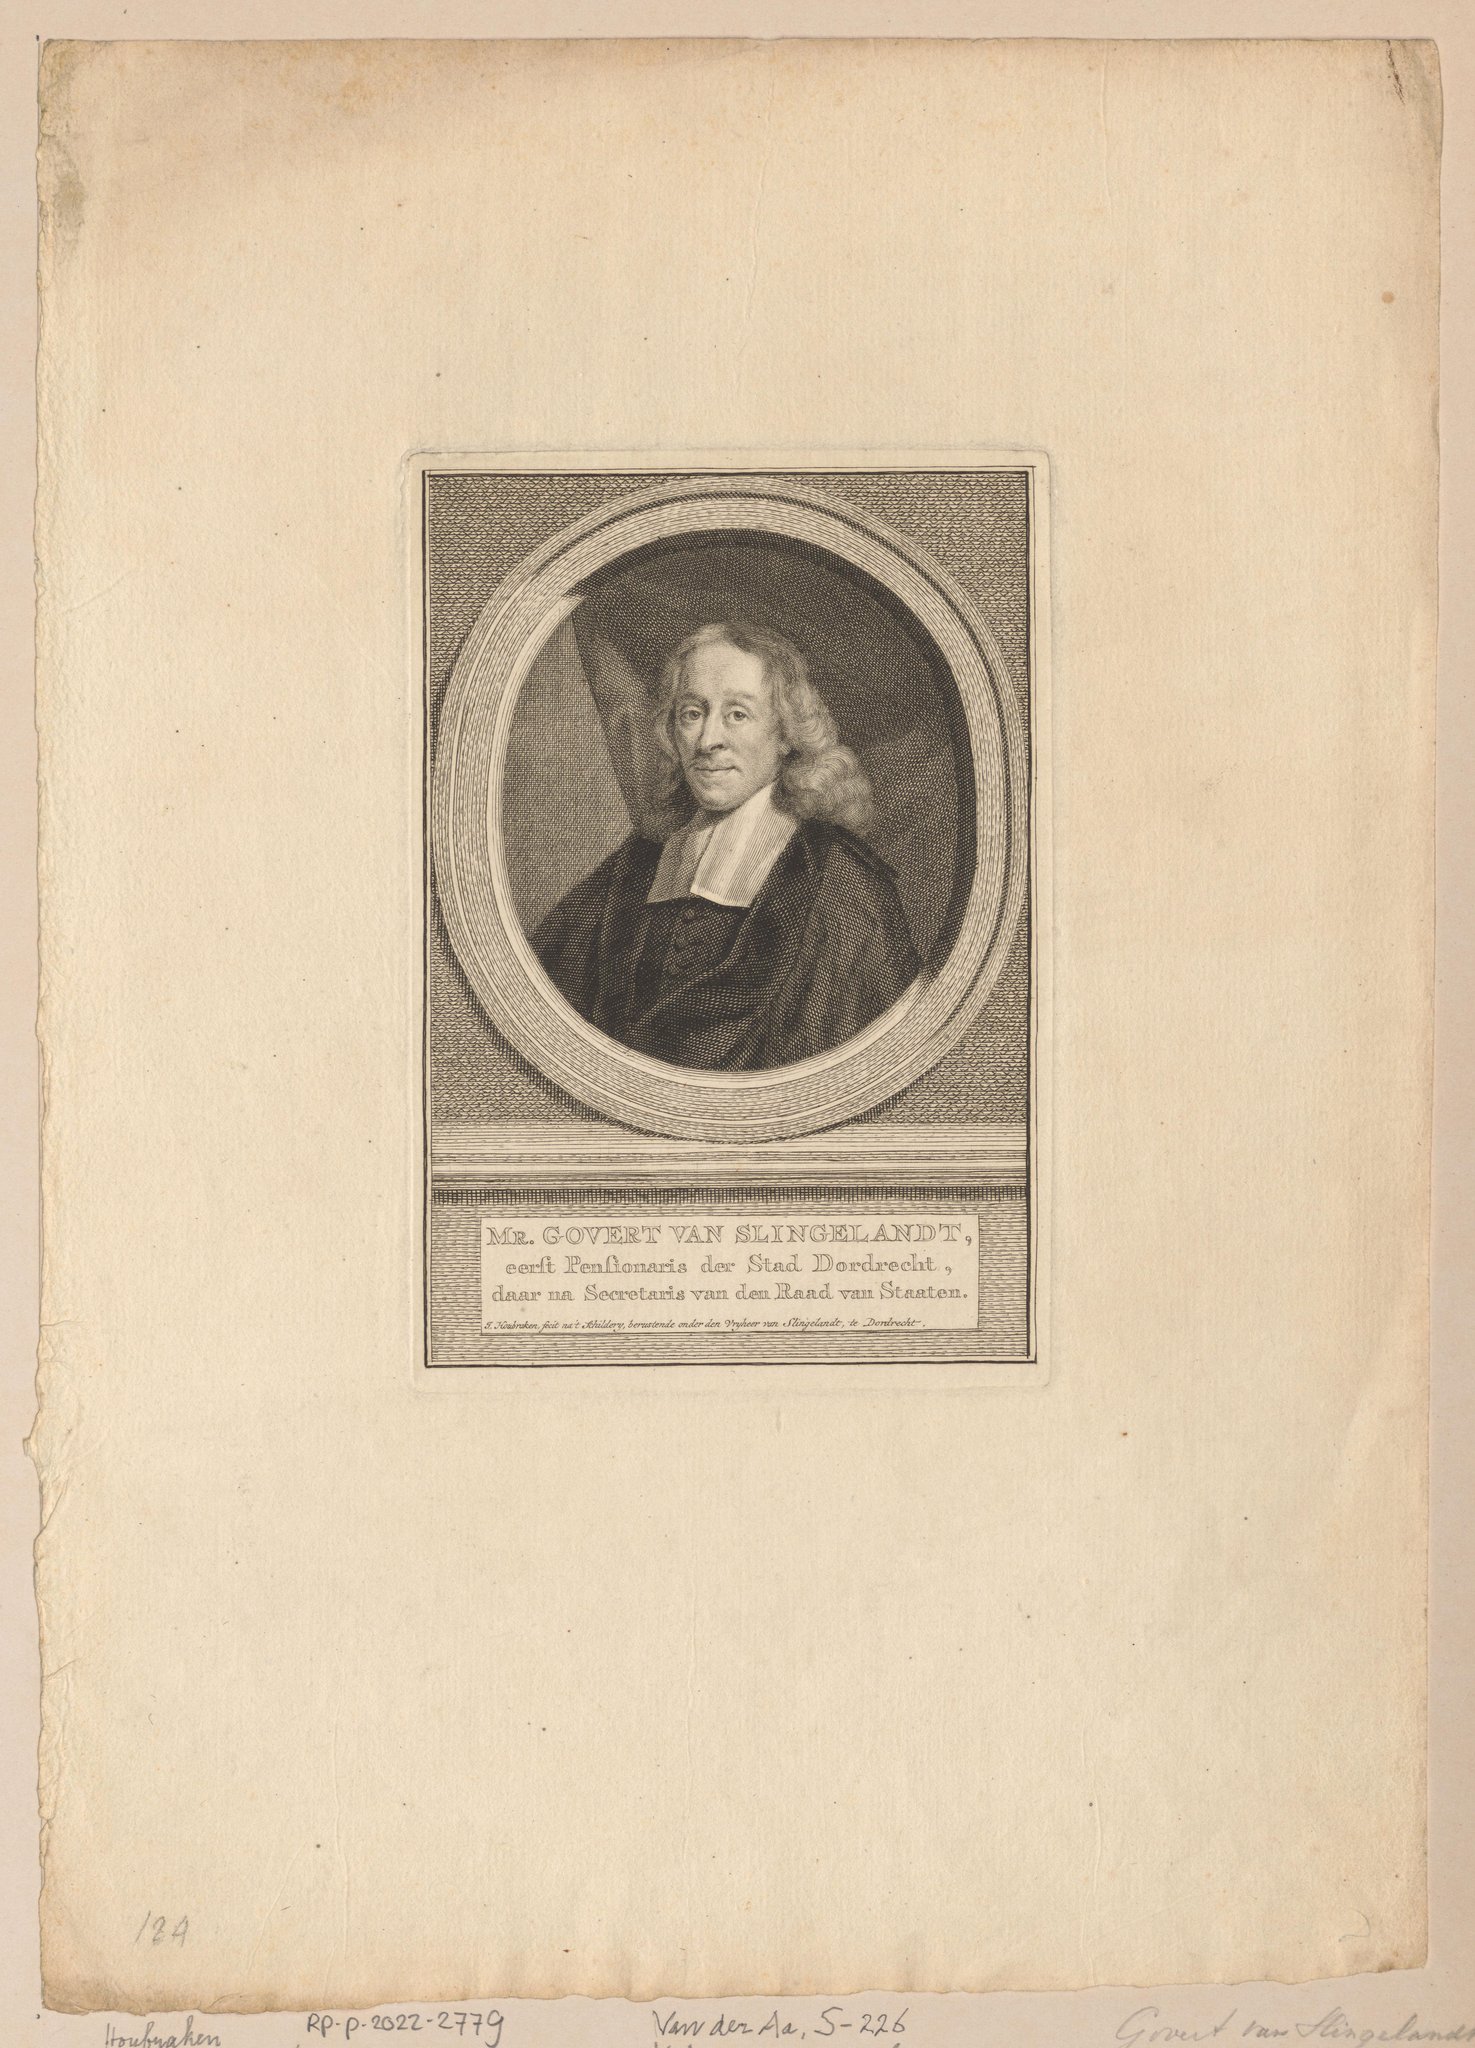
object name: print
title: Portret van Govert van Slingelandt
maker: jacob houbraken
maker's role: draughtsman, print maker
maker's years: 1698-1780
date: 1749-1780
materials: paper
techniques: engraving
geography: amsterdam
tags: historical persons, politician, e.g. party leader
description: Deze prent is oorspronkelijk bedoeld als aanvulling op Jan Wagenaars ‘Vaderlandsche historie’* en was zo vanaf 1796 verkrijgbaar bij Johannes Allart te Amsterdam. Voor de advertentie waarin Allart de 60 portretten en 7 platen, allen gegraveerd door Houbraken, ter aanvulling op Wagenaars ‘Vaderlandsche historie’ aanbiedt, zie RP-P-OB-77.766. *Van dit werk zijn in de achttiende eeuw meerdere uitgaves verschenen, zoals: Wagenaar, Jan. Vaderlandsche historie, vervattende de geschiedenissen der Vereenigde Nederlanden (…). 21 delen. Amsterdam: Isaak Tirion, 1749-1759. Wagenaar, Jan. Vaderlandsche historie, vervattende de geschiedenissen der nu Vereenigde Nederlanden (…). 21 delen. Amsterdam: weduwe Isaak Tirion, 1770. Wagenaar, Jan. Vaderlandsche historie, vervattende de geschiedenissen der nu Vereenigde Nederlanden (…). 21 delen. Amsterdam, Leiden, Dordrecht en Harlingen: P. Schouten e.a., 1782. Wagenaar, Jan. Vaderlandsche historie, vervattende de geschiedenissen der nu Vereenigde Nederlanden (…). 21 delen. Amsterdam: Johannes Allart, 1790-1796.